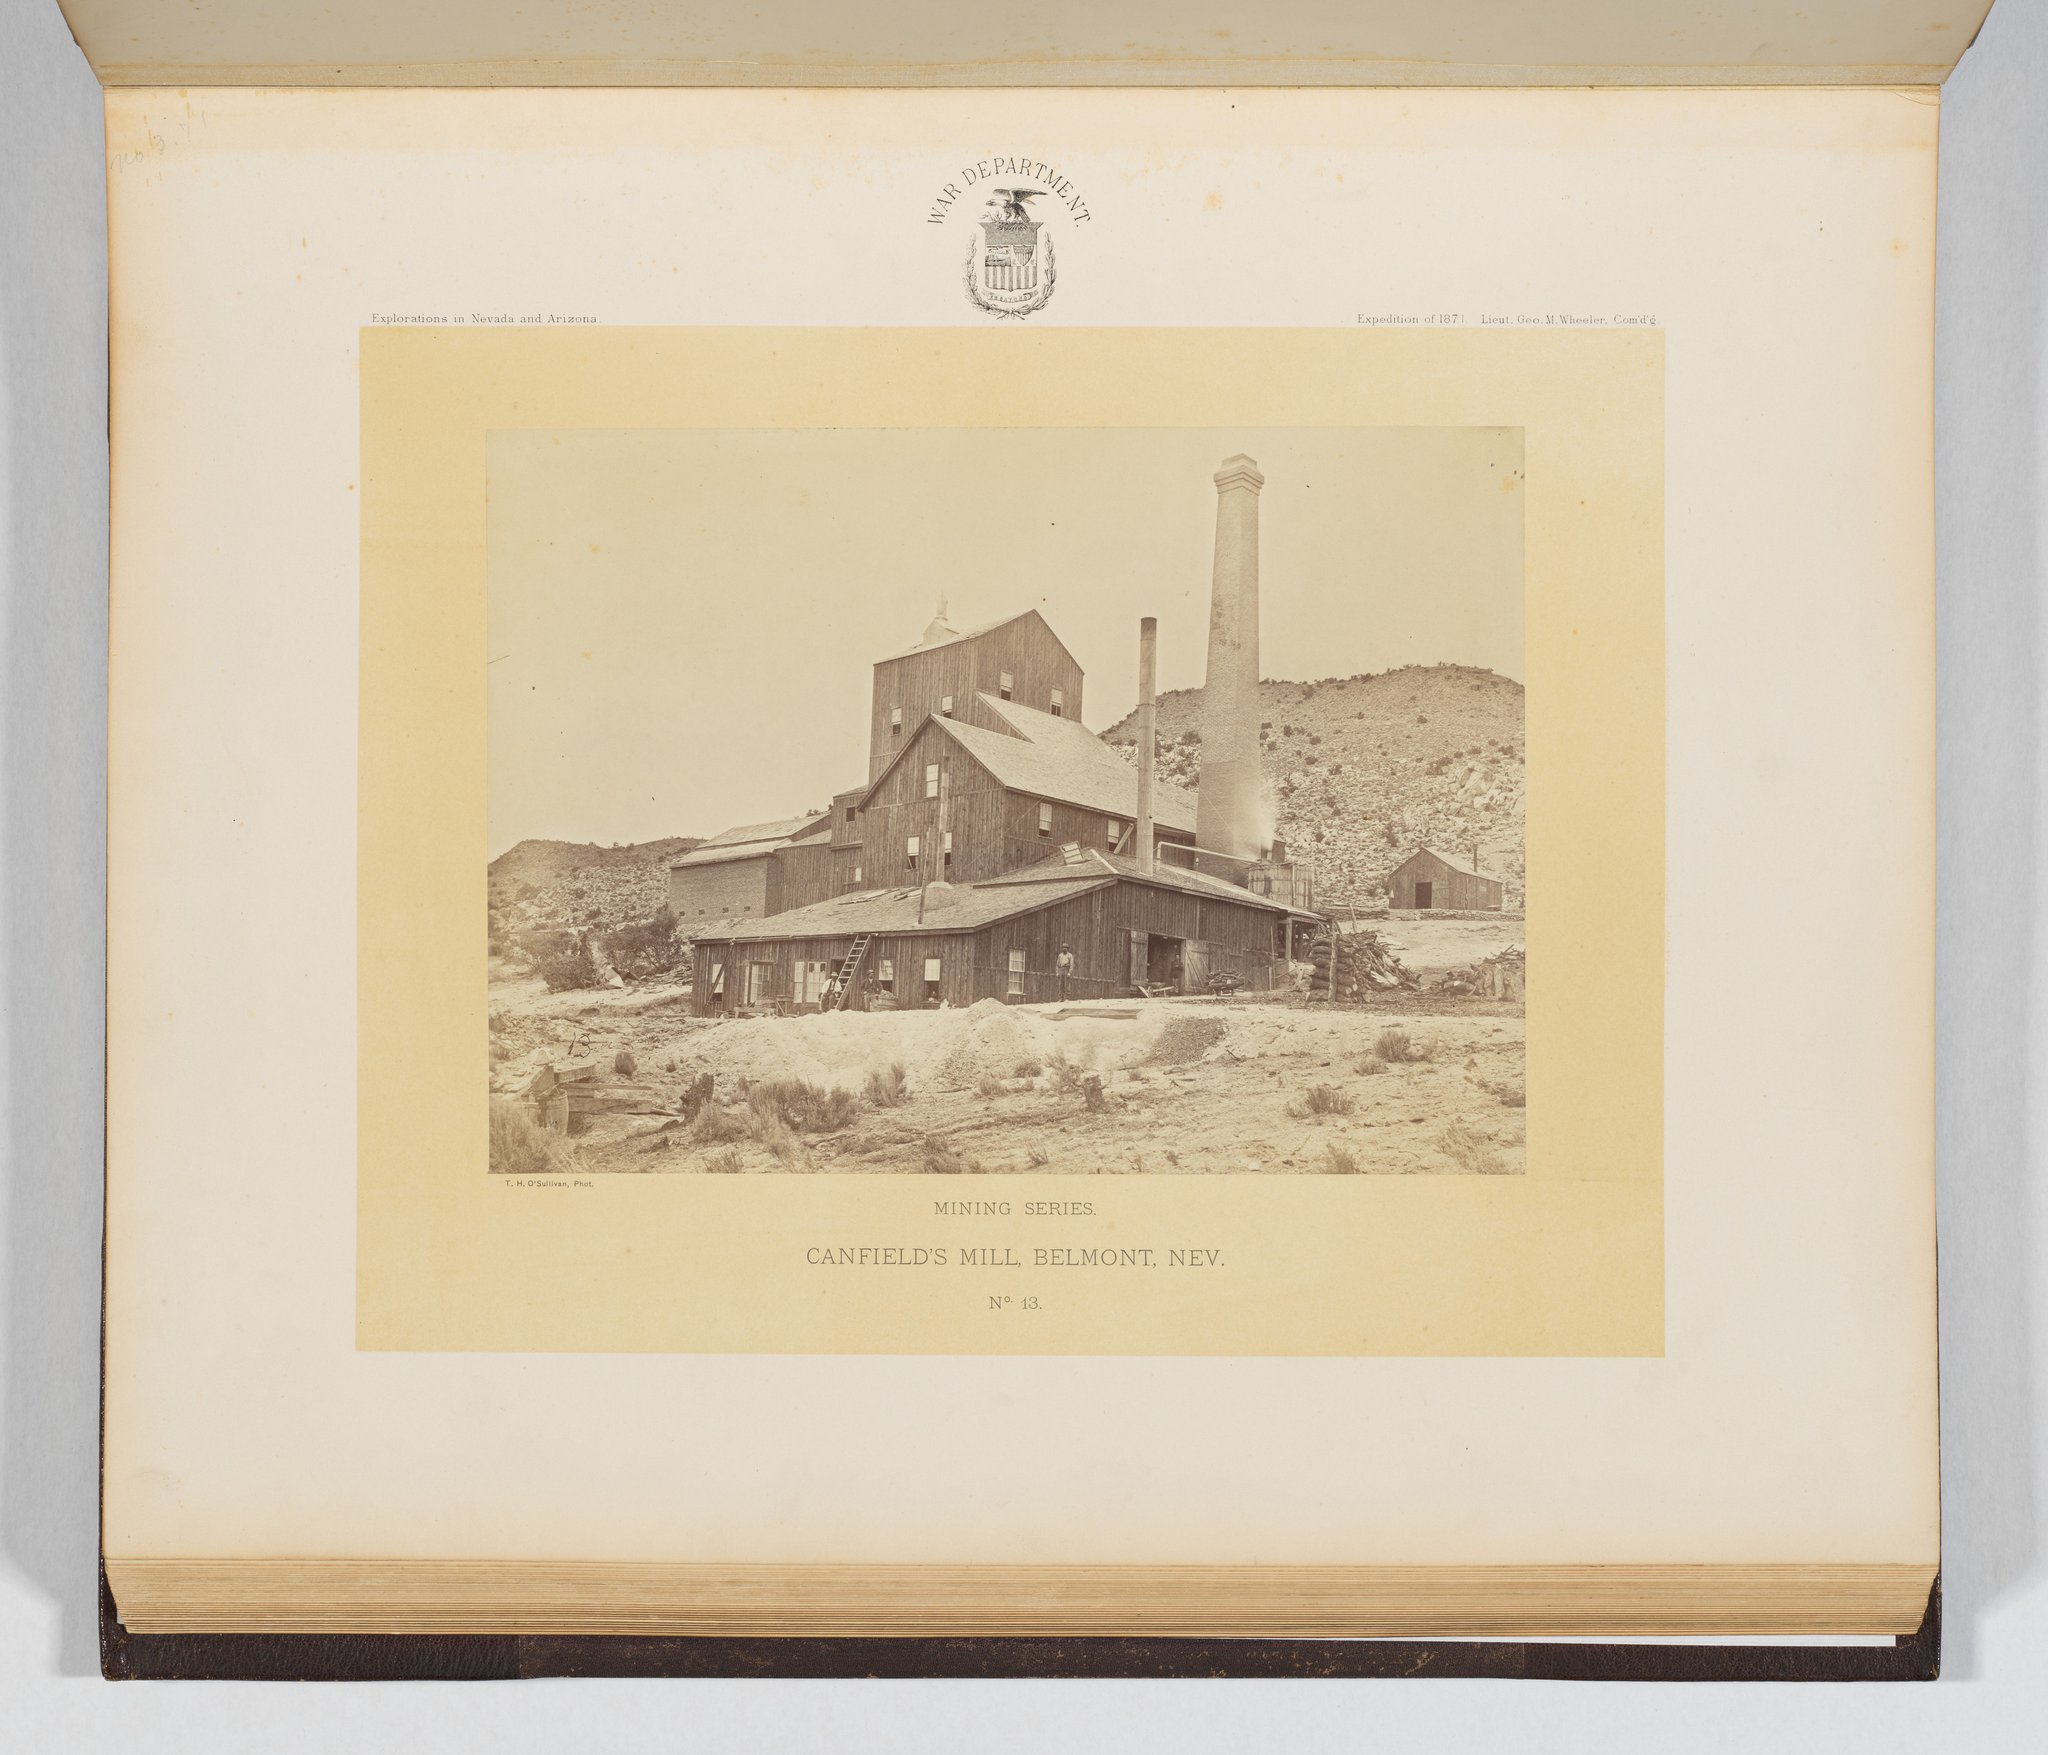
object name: photograph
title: Canfield's Mill, Belmont, Nevada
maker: timothy h. o'sullivan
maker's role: artist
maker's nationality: american, born ireland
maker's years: 1840-1882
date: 1871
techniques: albumen silver print, glass negative